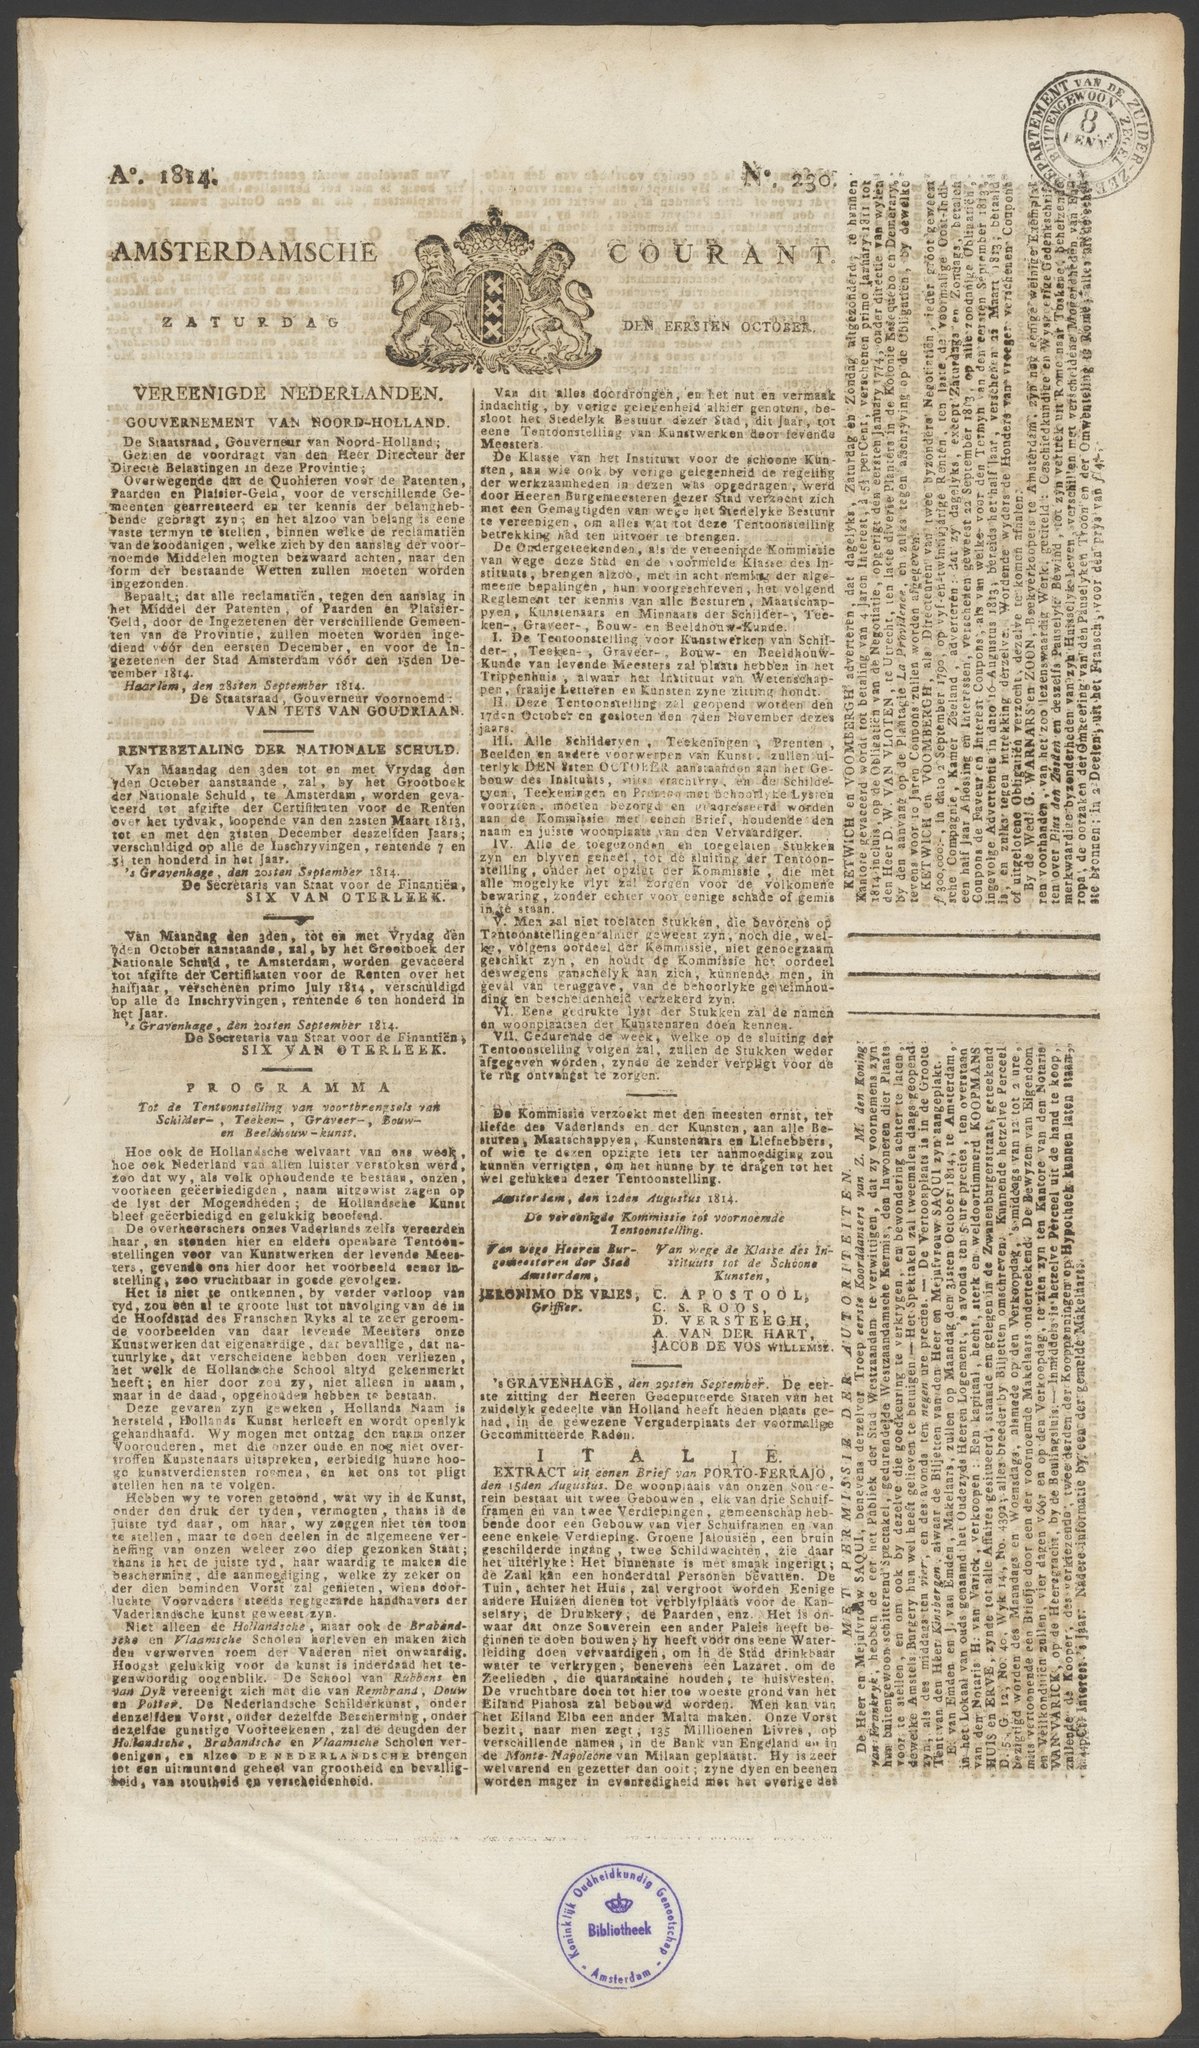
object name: newspaper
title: Amsterdamsche Courant, 1 oktober 1814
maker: jacobus van bonga jr.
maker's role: printer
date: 1814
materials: paper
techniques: letterpress printing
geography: amsterdam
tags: newspaper, news-sheet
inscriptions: collector's mark: ‘Bibliotheek Koninklijk Oudheidkundig Genootschap Amsterdam’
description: Exemplaar van de krant 'Amsterdamsche Courant' van 1 oktober 1814. Dubbelbladig, alle zijden bedrukt. Bovenaan een vignet met het stadswapen. Rechtsboven een stempel betaalde accijnzen. Onderwerpsrubrieken binnen de Atlas Zeden en Gewoonten: Regeering, Officieele Nieuwsbladen.